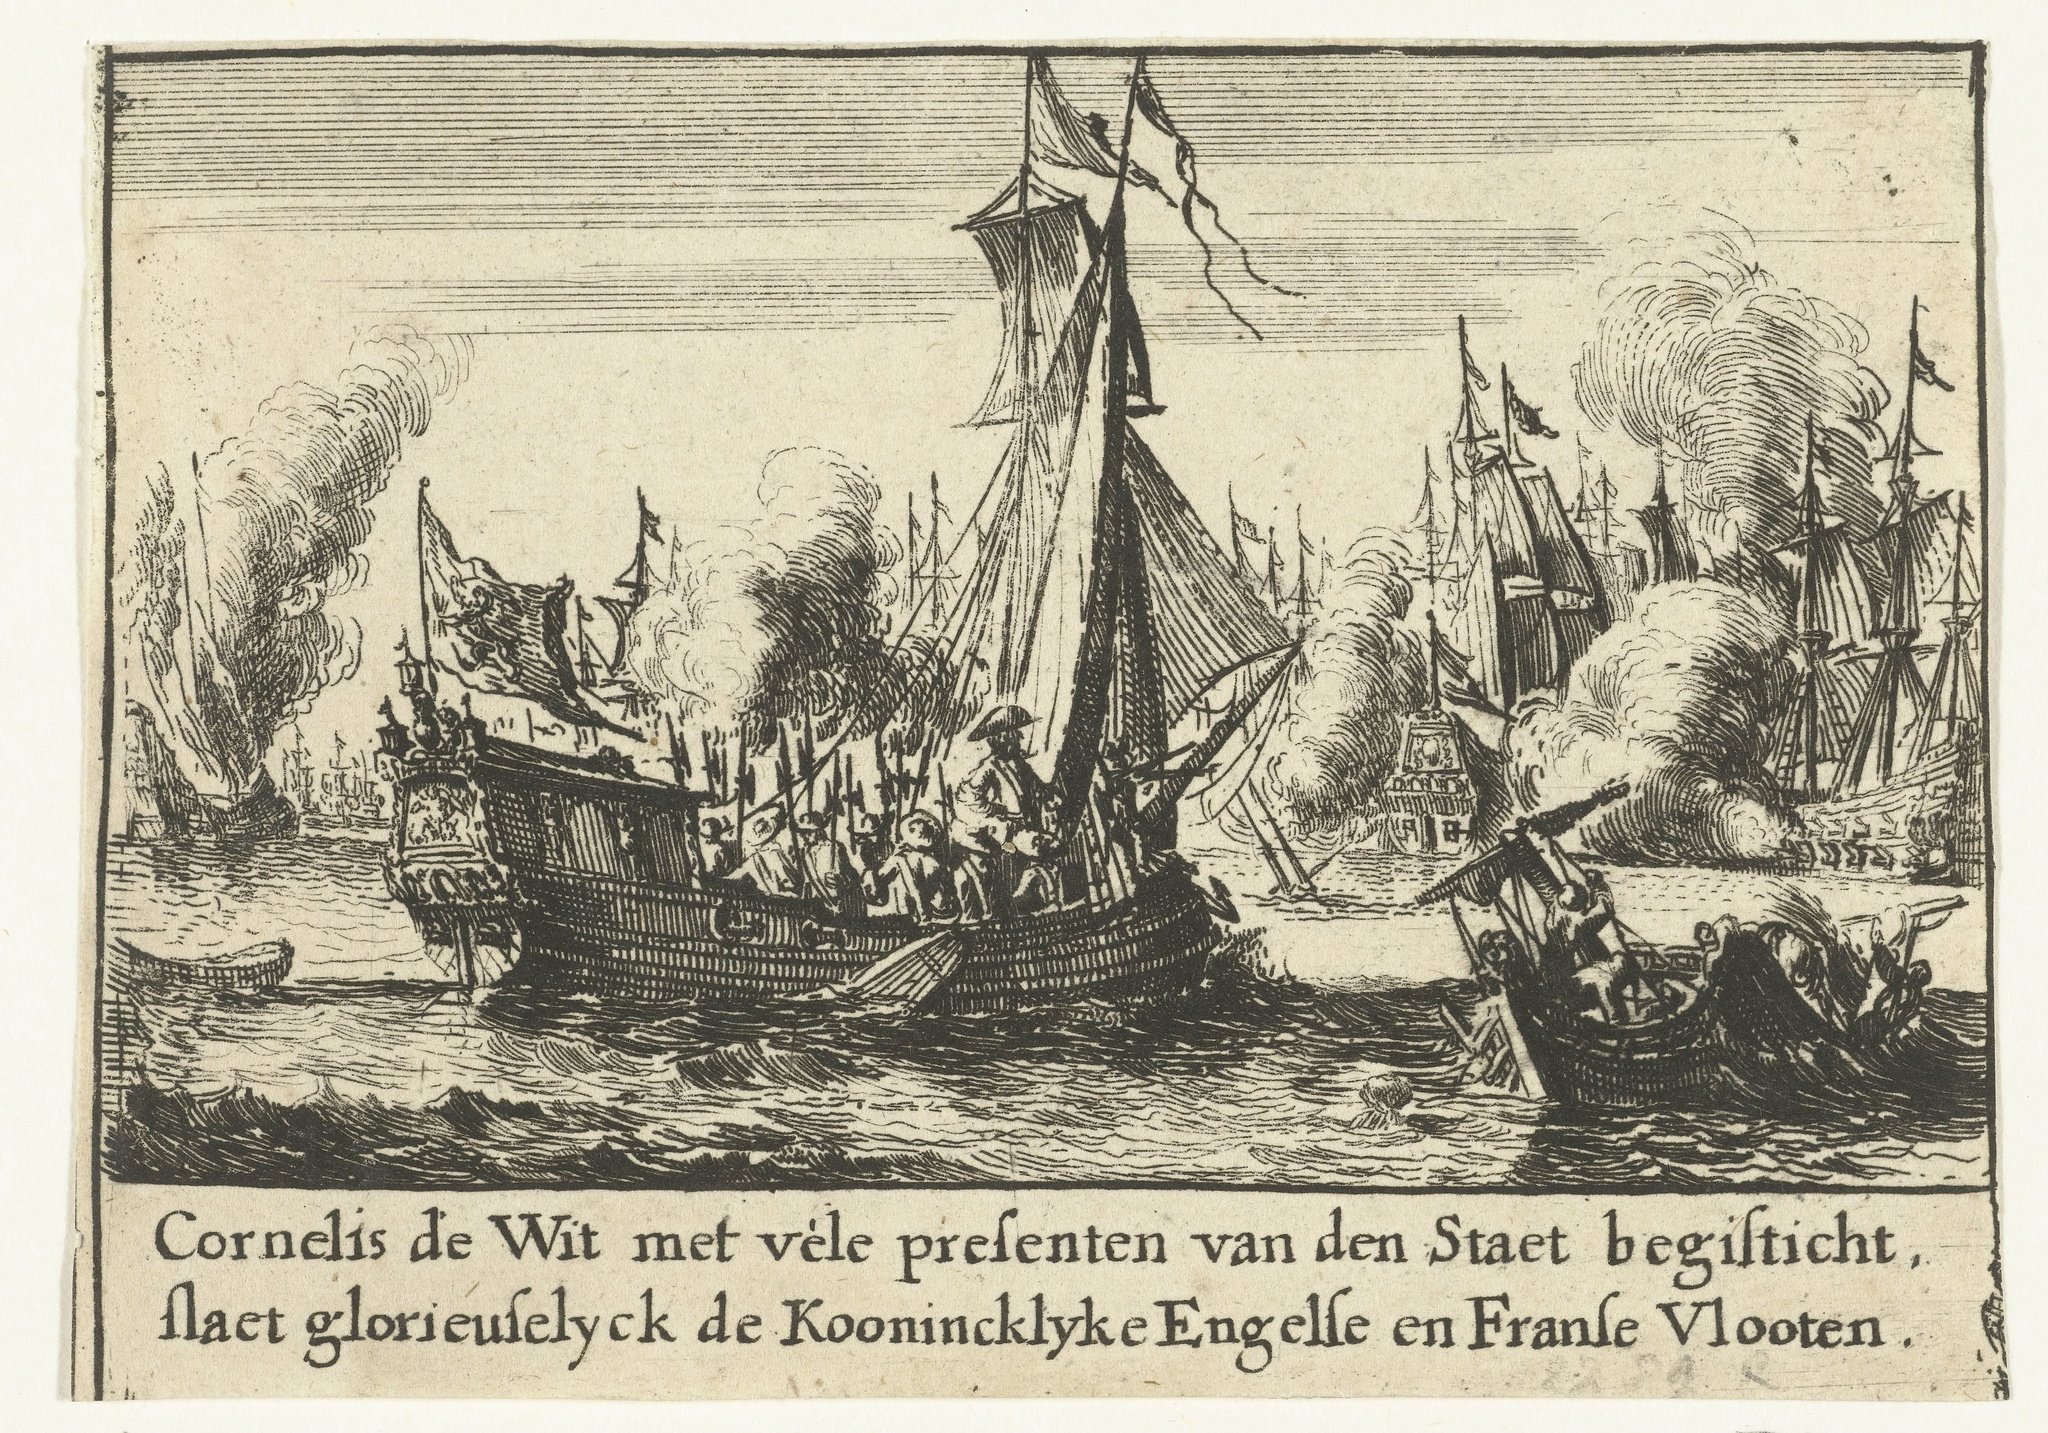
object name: print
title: Cornelis de Witt leidt de aanval op de Engelse vloot tijdens de Tocht naar Chatham, 1667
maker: romeyn de hooghe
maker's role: draughtsman, goldsmith, painter, print maker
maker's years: 1645-1708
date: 1675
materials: paper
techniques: etching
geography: northern netherlands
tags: dordrecht, cornelis de witt, battle (+ naval force), raid on the medway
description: Cornelis de Witt leidt de aanval op de Engelse vloot, 20-23 juni 1667. Episode uit de Tocht naar Chatham tijdens de Tweede Engelse Oorlog. Fragment van de grote prent over de gebroeders De Witt: Witten Wonder Spiegel (1675).